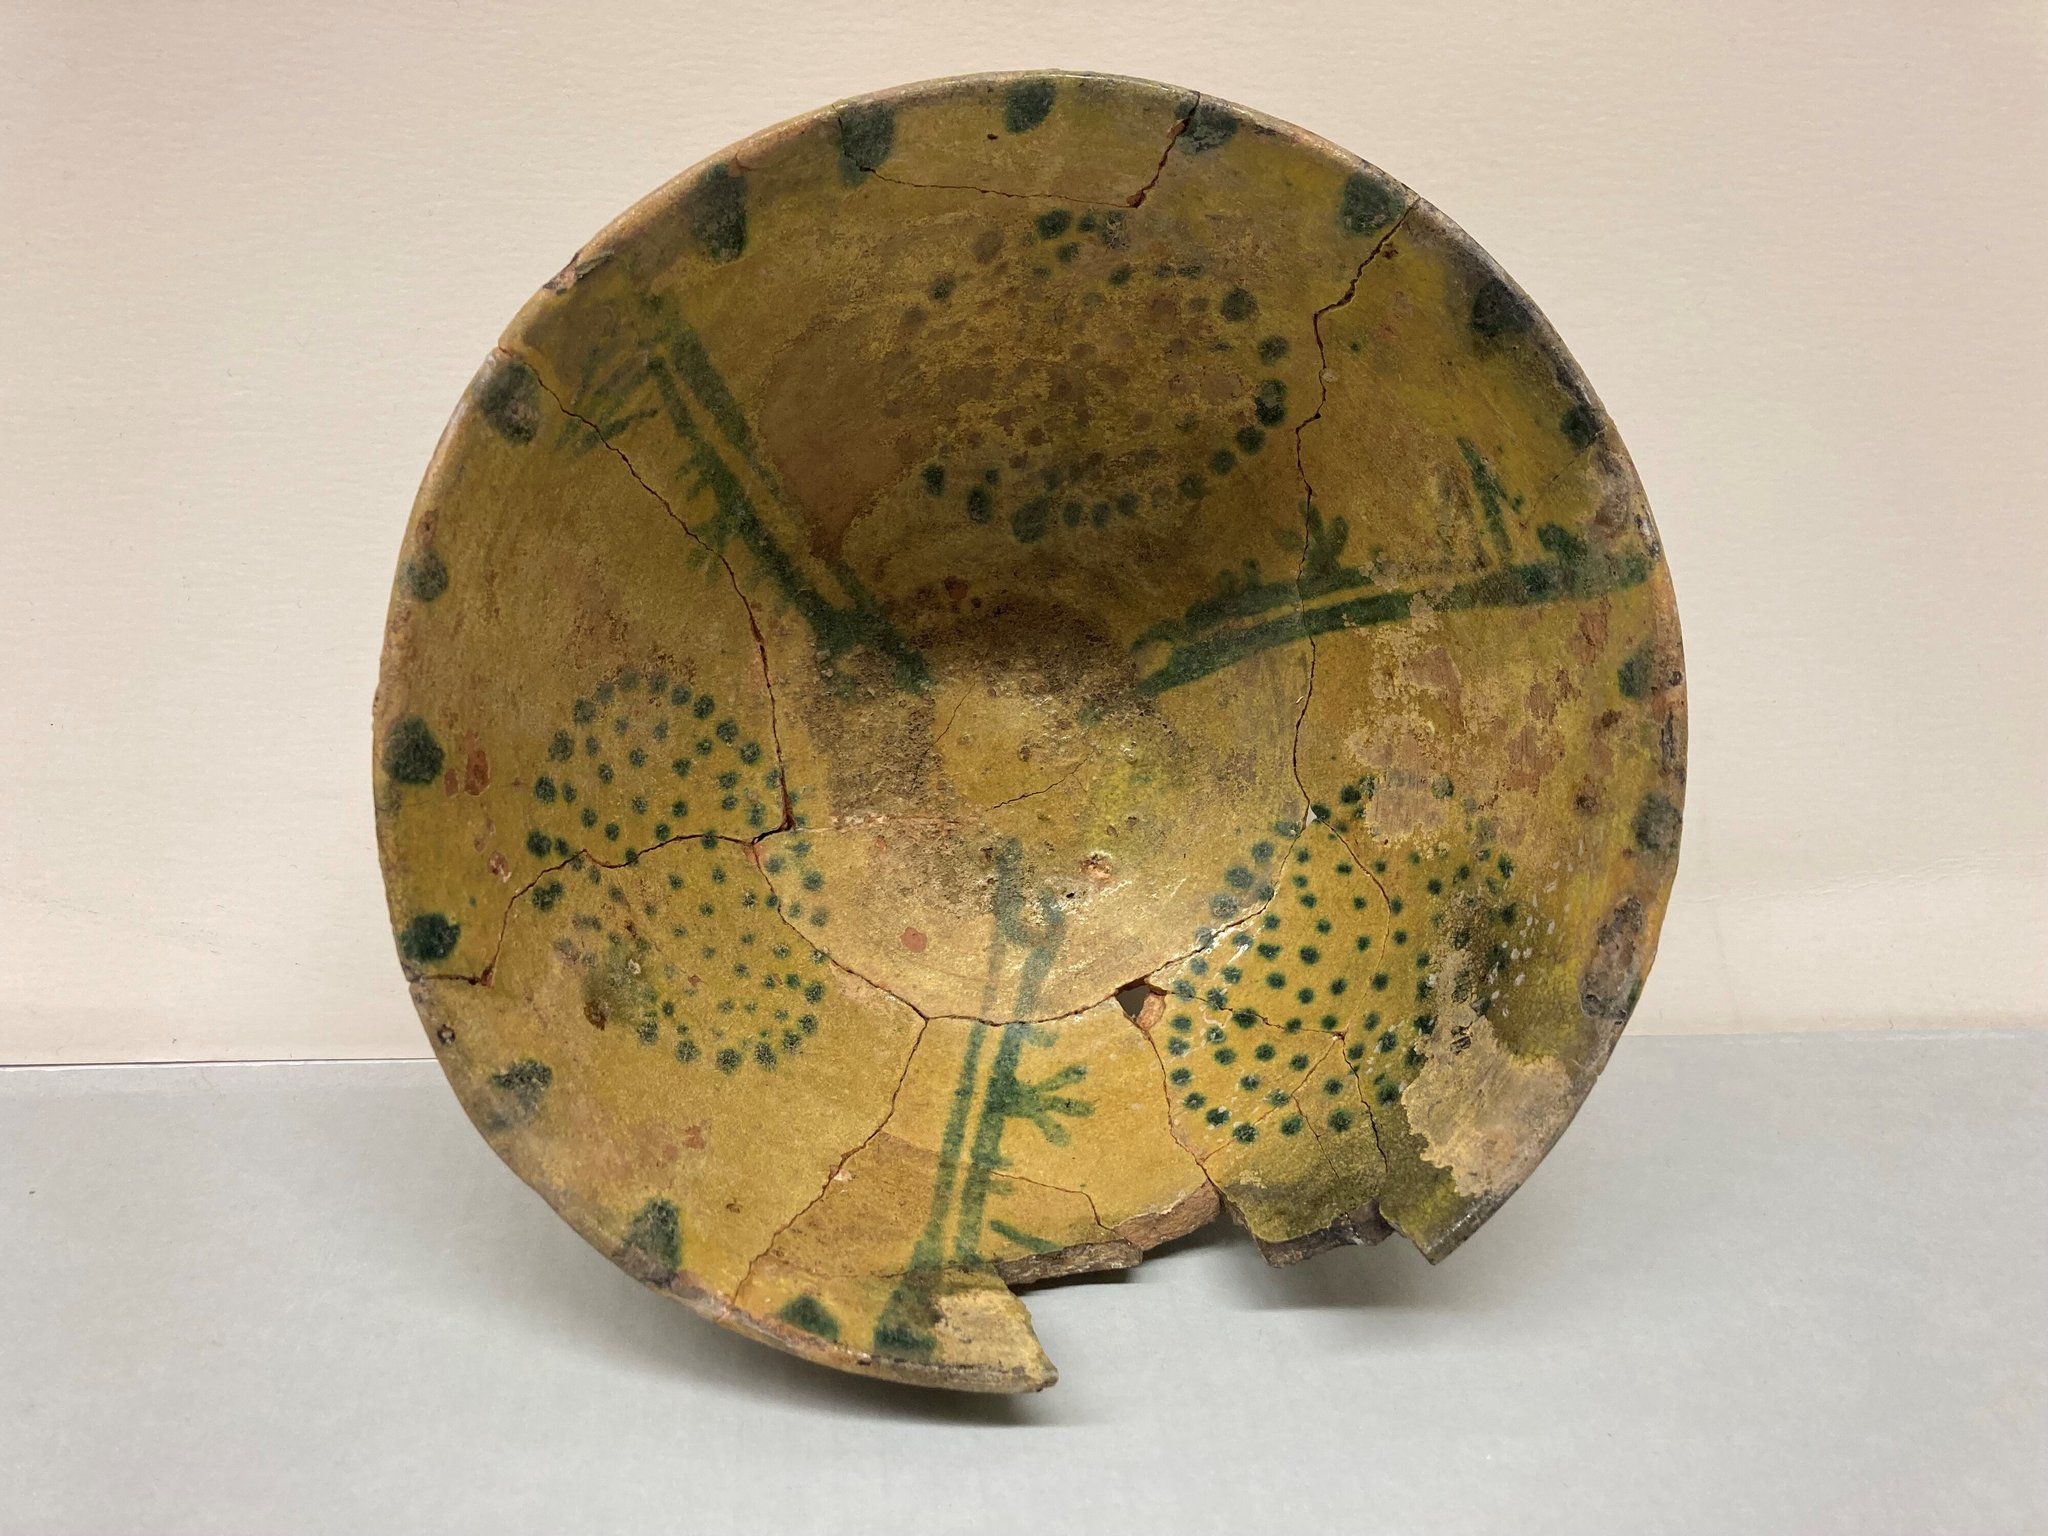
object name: bowl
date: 801-1000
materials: earthenware, glaze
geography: iran